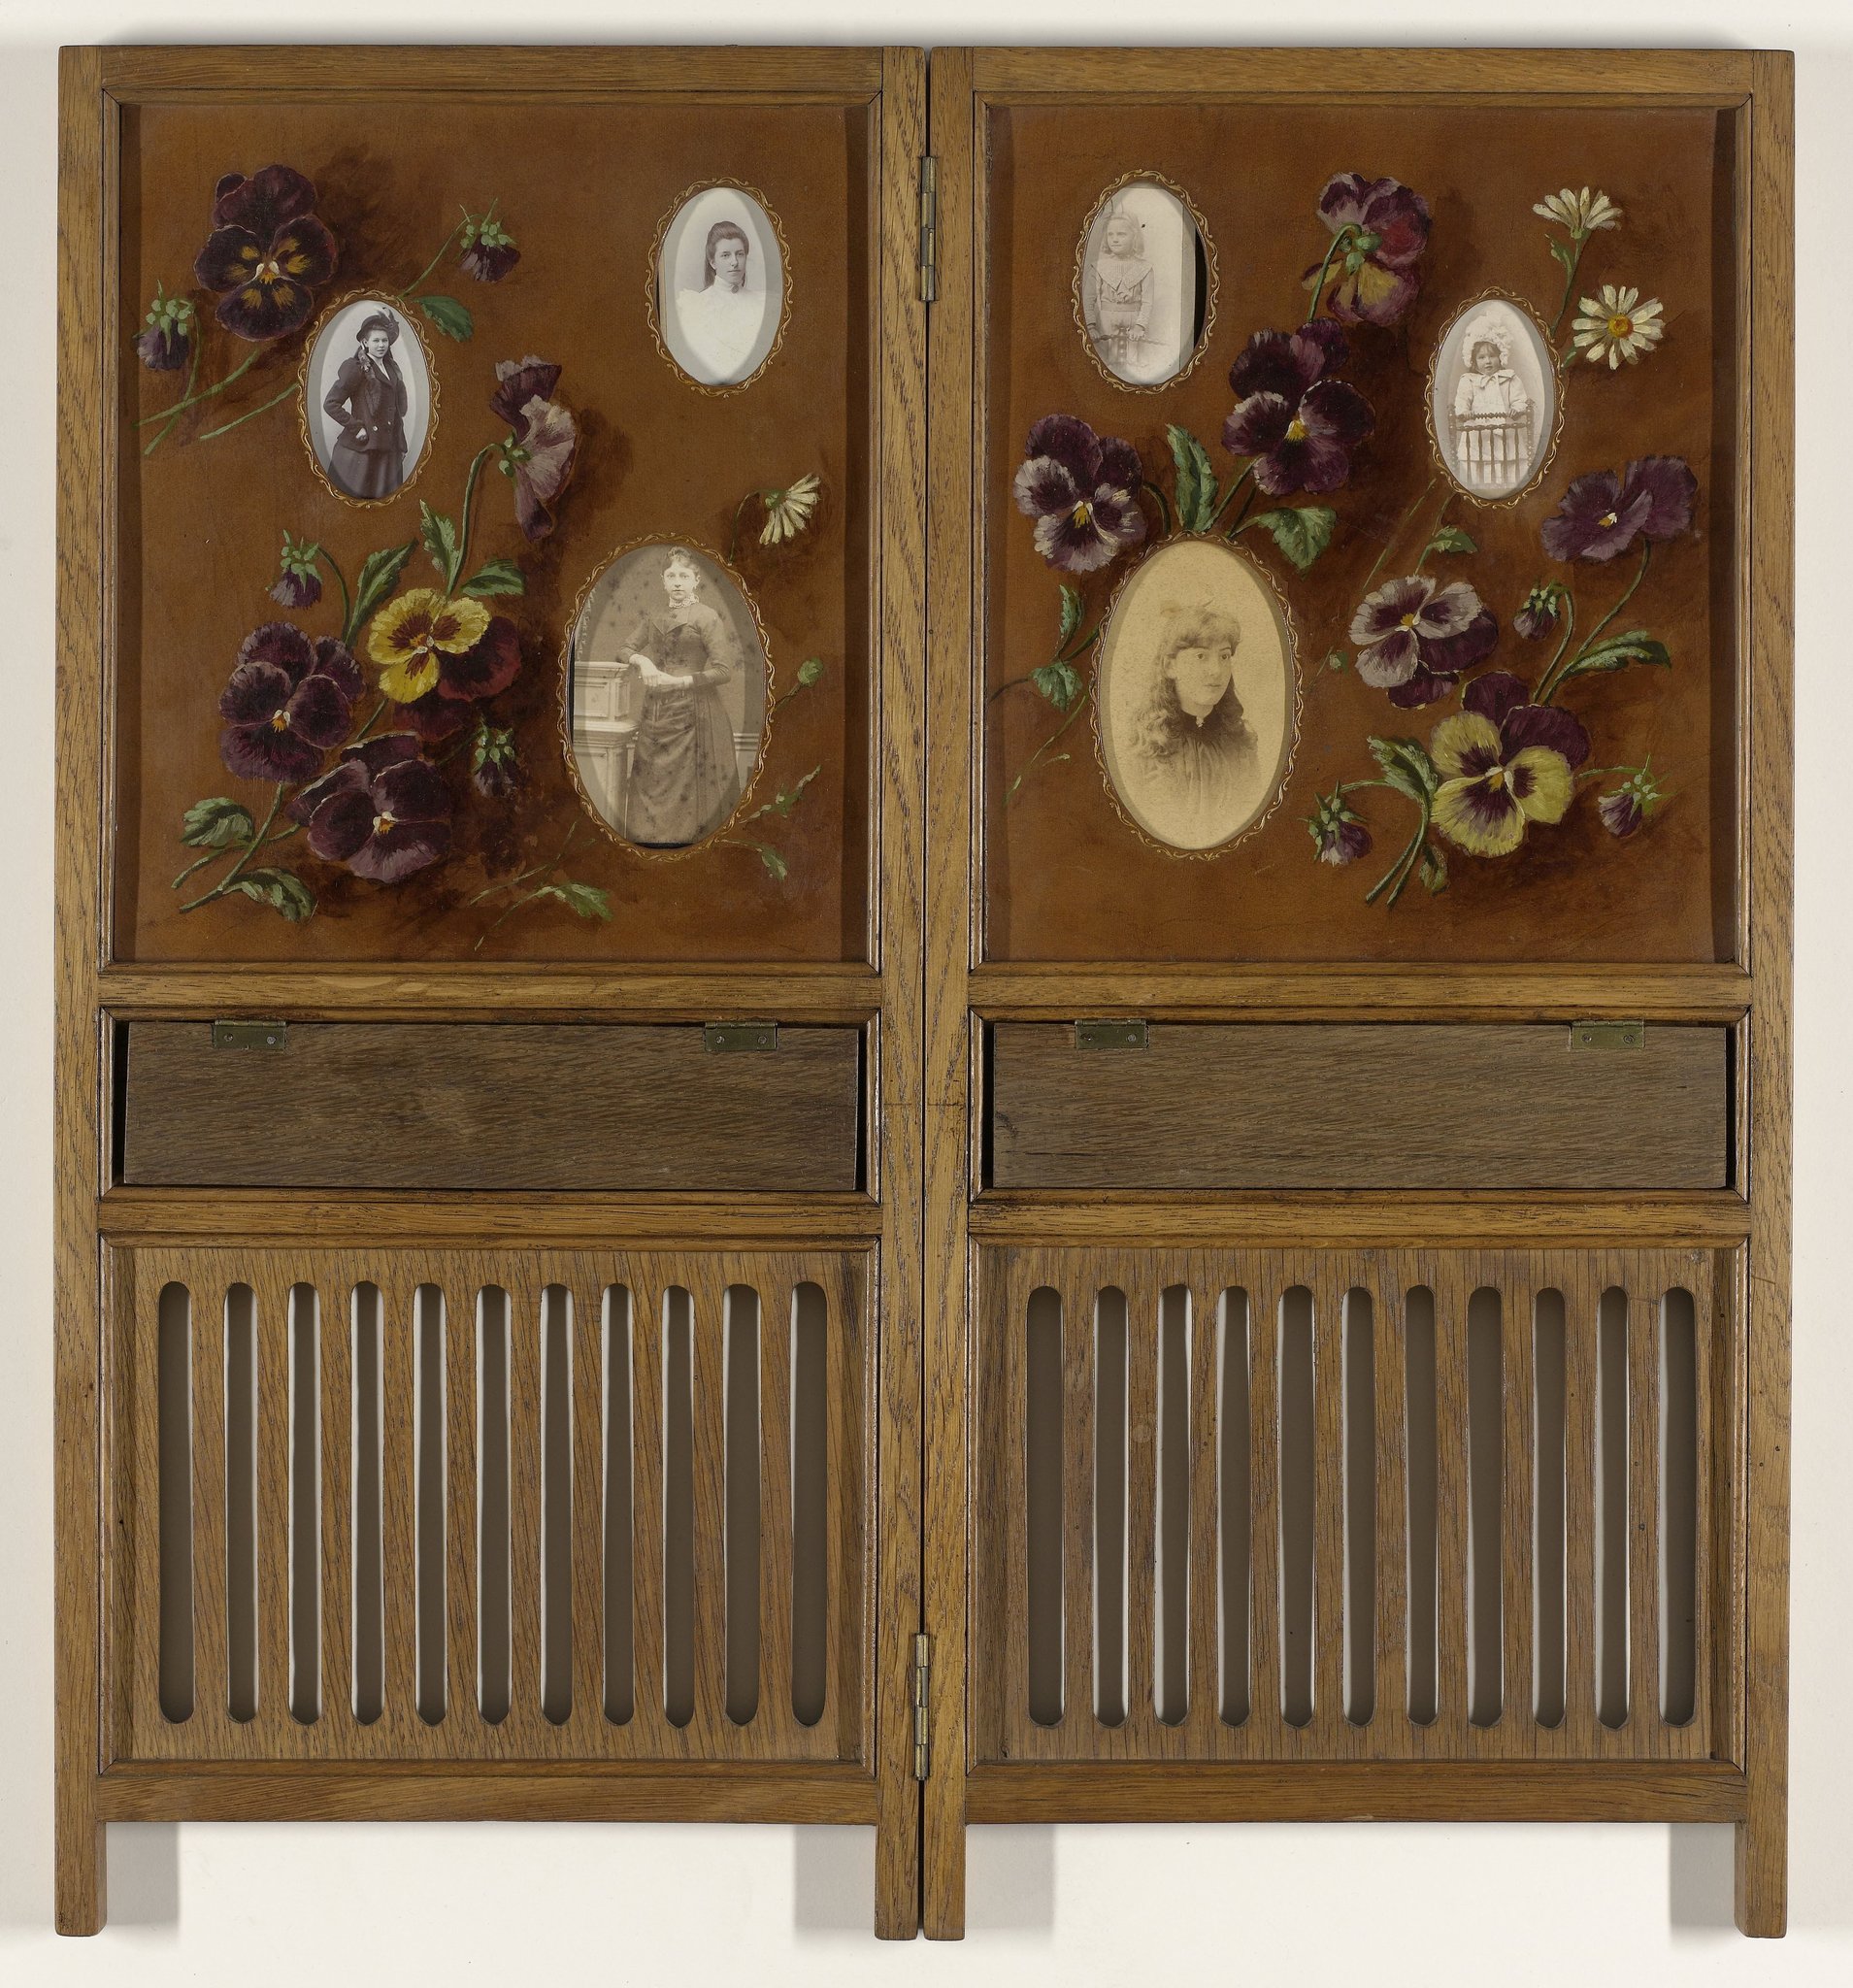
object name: vouwscherm, kamerscherm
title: Kamerscherm met zes portretten van onbekende mensen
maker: Anonymous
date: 1895-1905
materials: paper, paint, metal, textile, wood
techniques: albumen print, brush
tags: adult woman, historical persons - bb - woman, girl (child between toddler and youth)